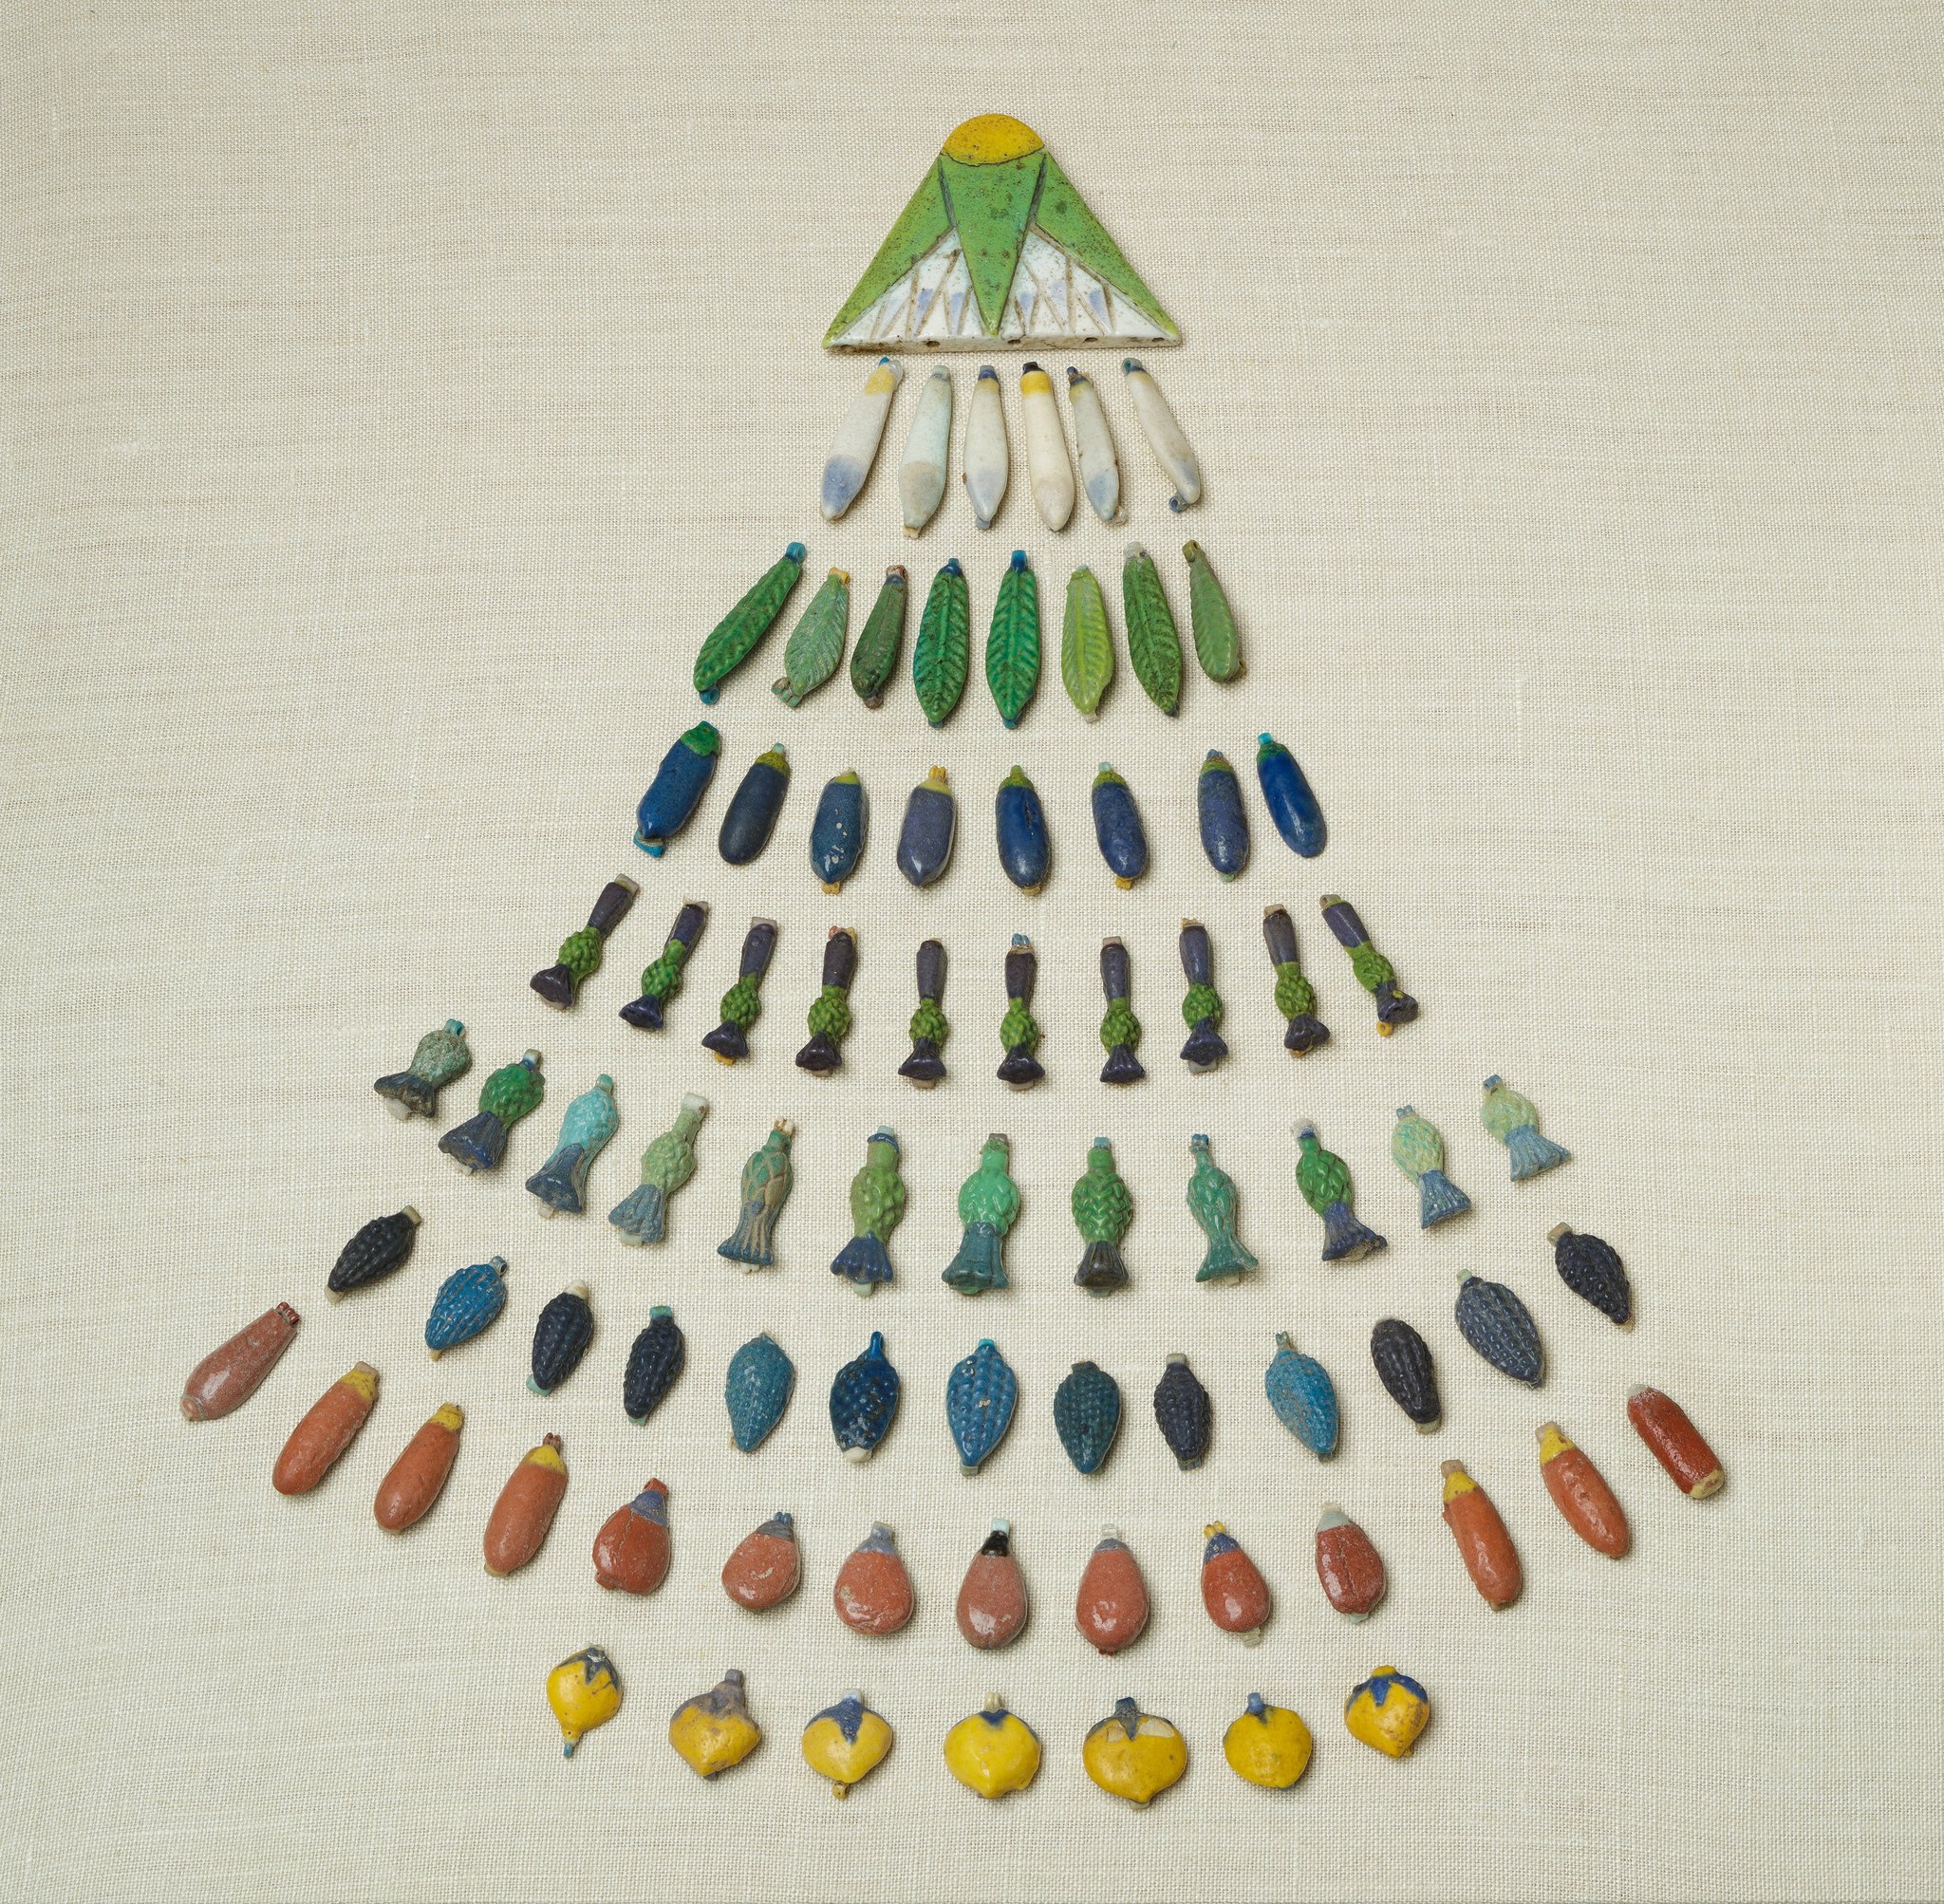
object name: bead, terminal, pendant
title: Jewelry Elements for a Broad Collar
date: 1353-1336 BCE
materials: faience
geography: egypt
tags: fruit